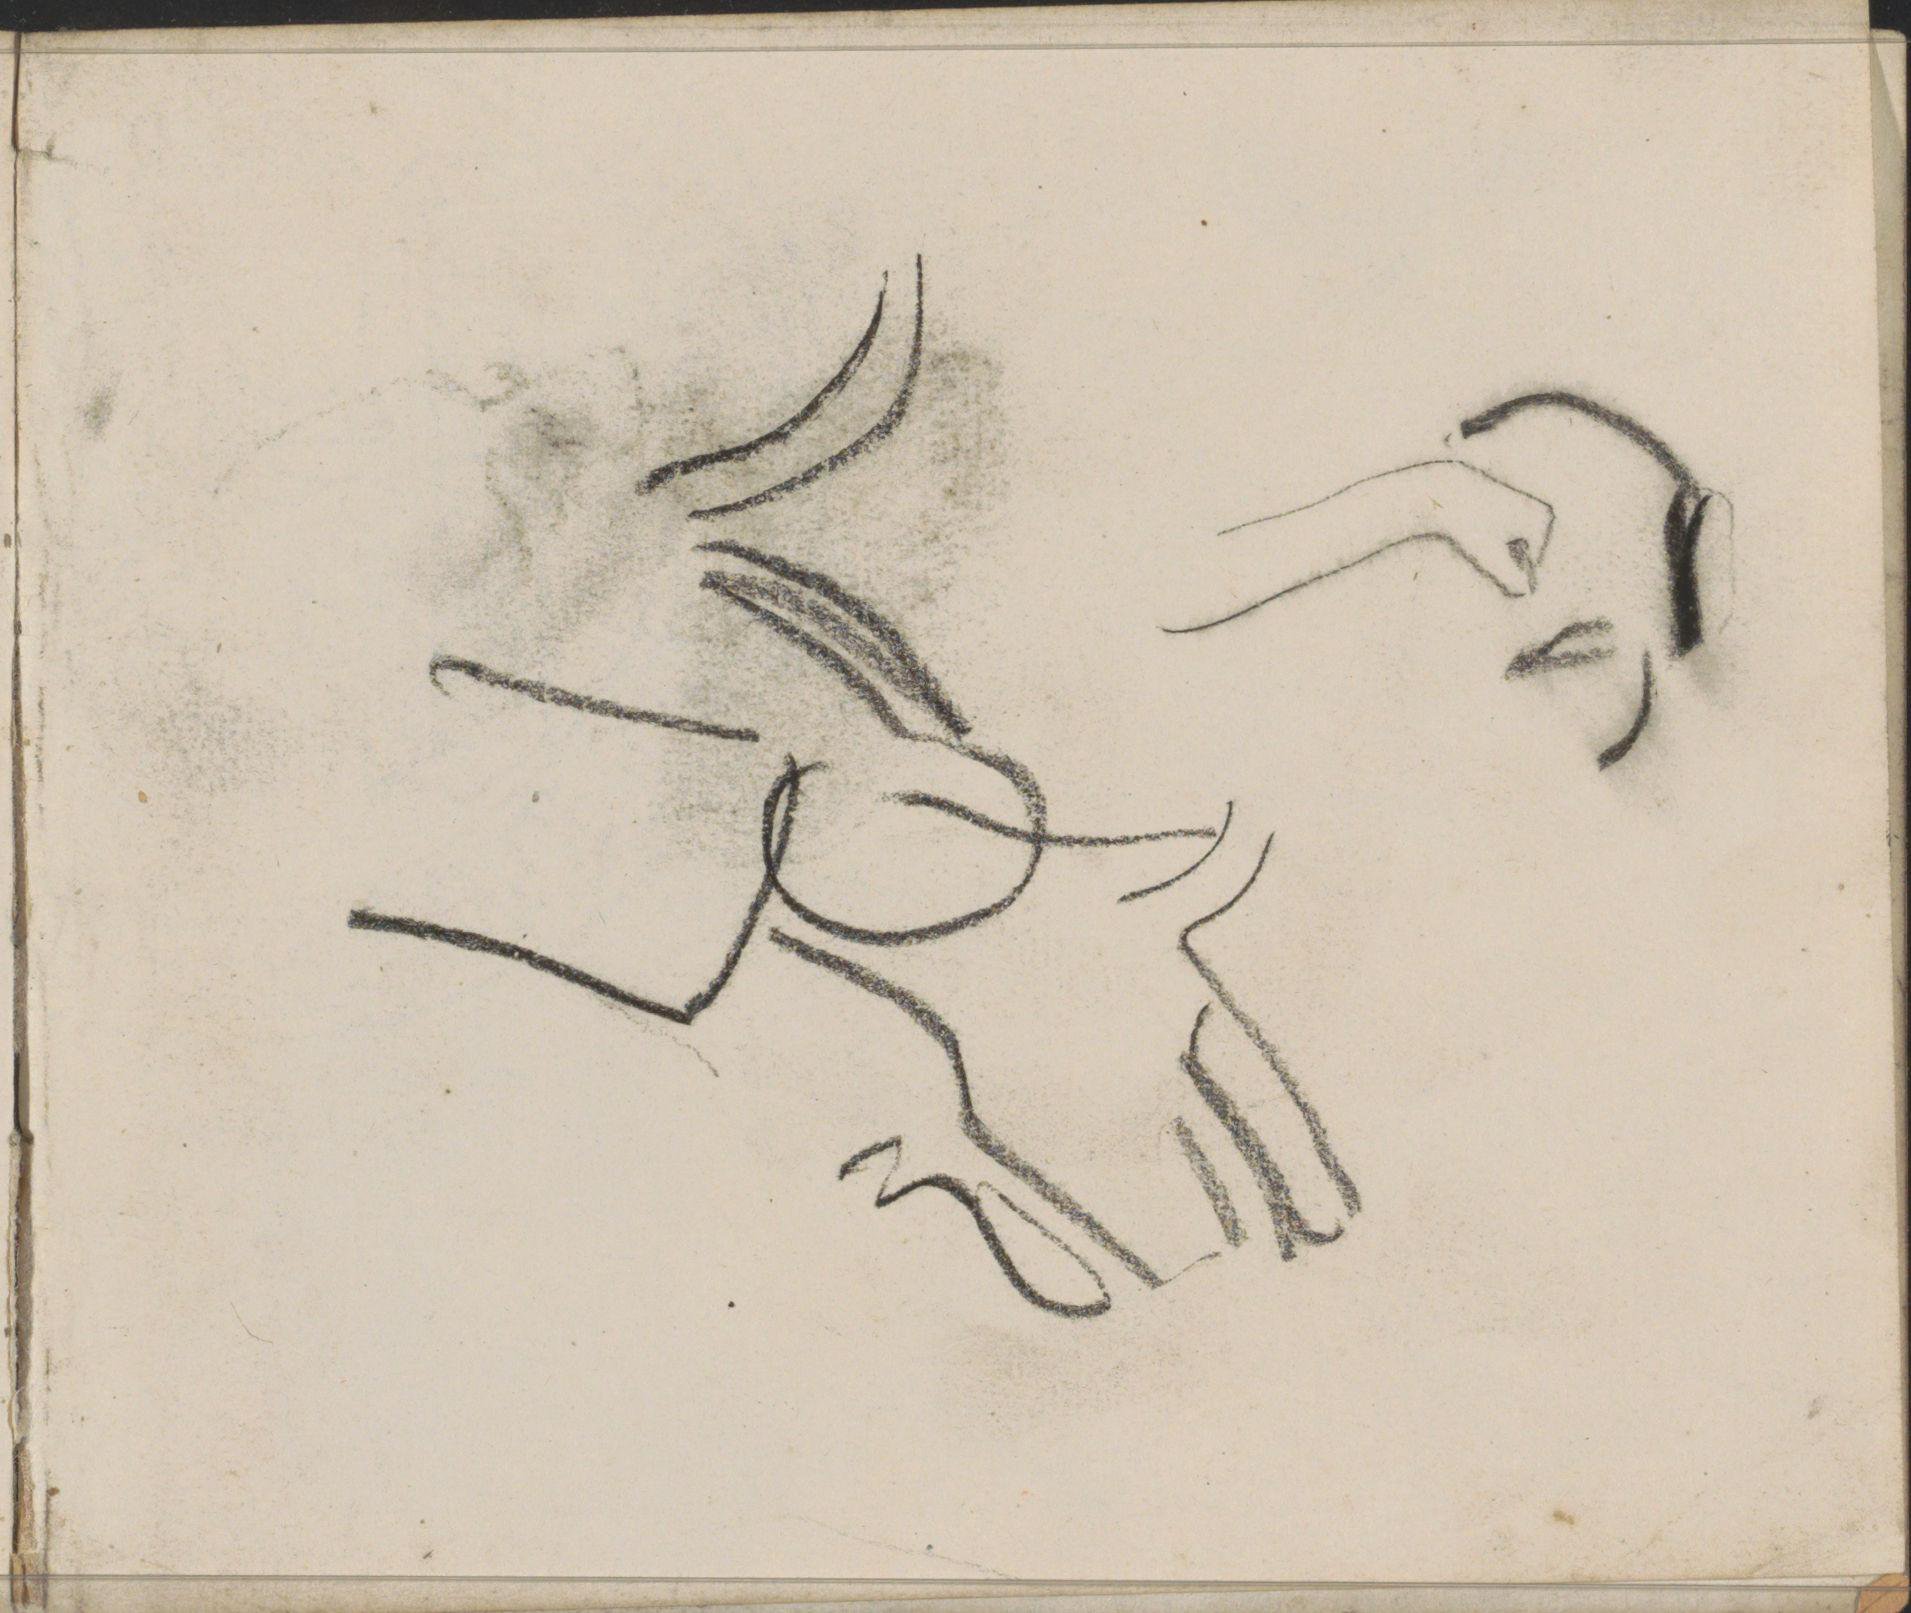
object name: sketchbook leaf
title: Hand en een onderarm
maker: carel adolph lion cachet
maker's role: draughtsman, print maker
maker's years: 1864-1945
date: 1895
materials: chalk, paper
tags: lower arm, hand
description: Blad 11 recto uit een schetsboek met 11 bladen.